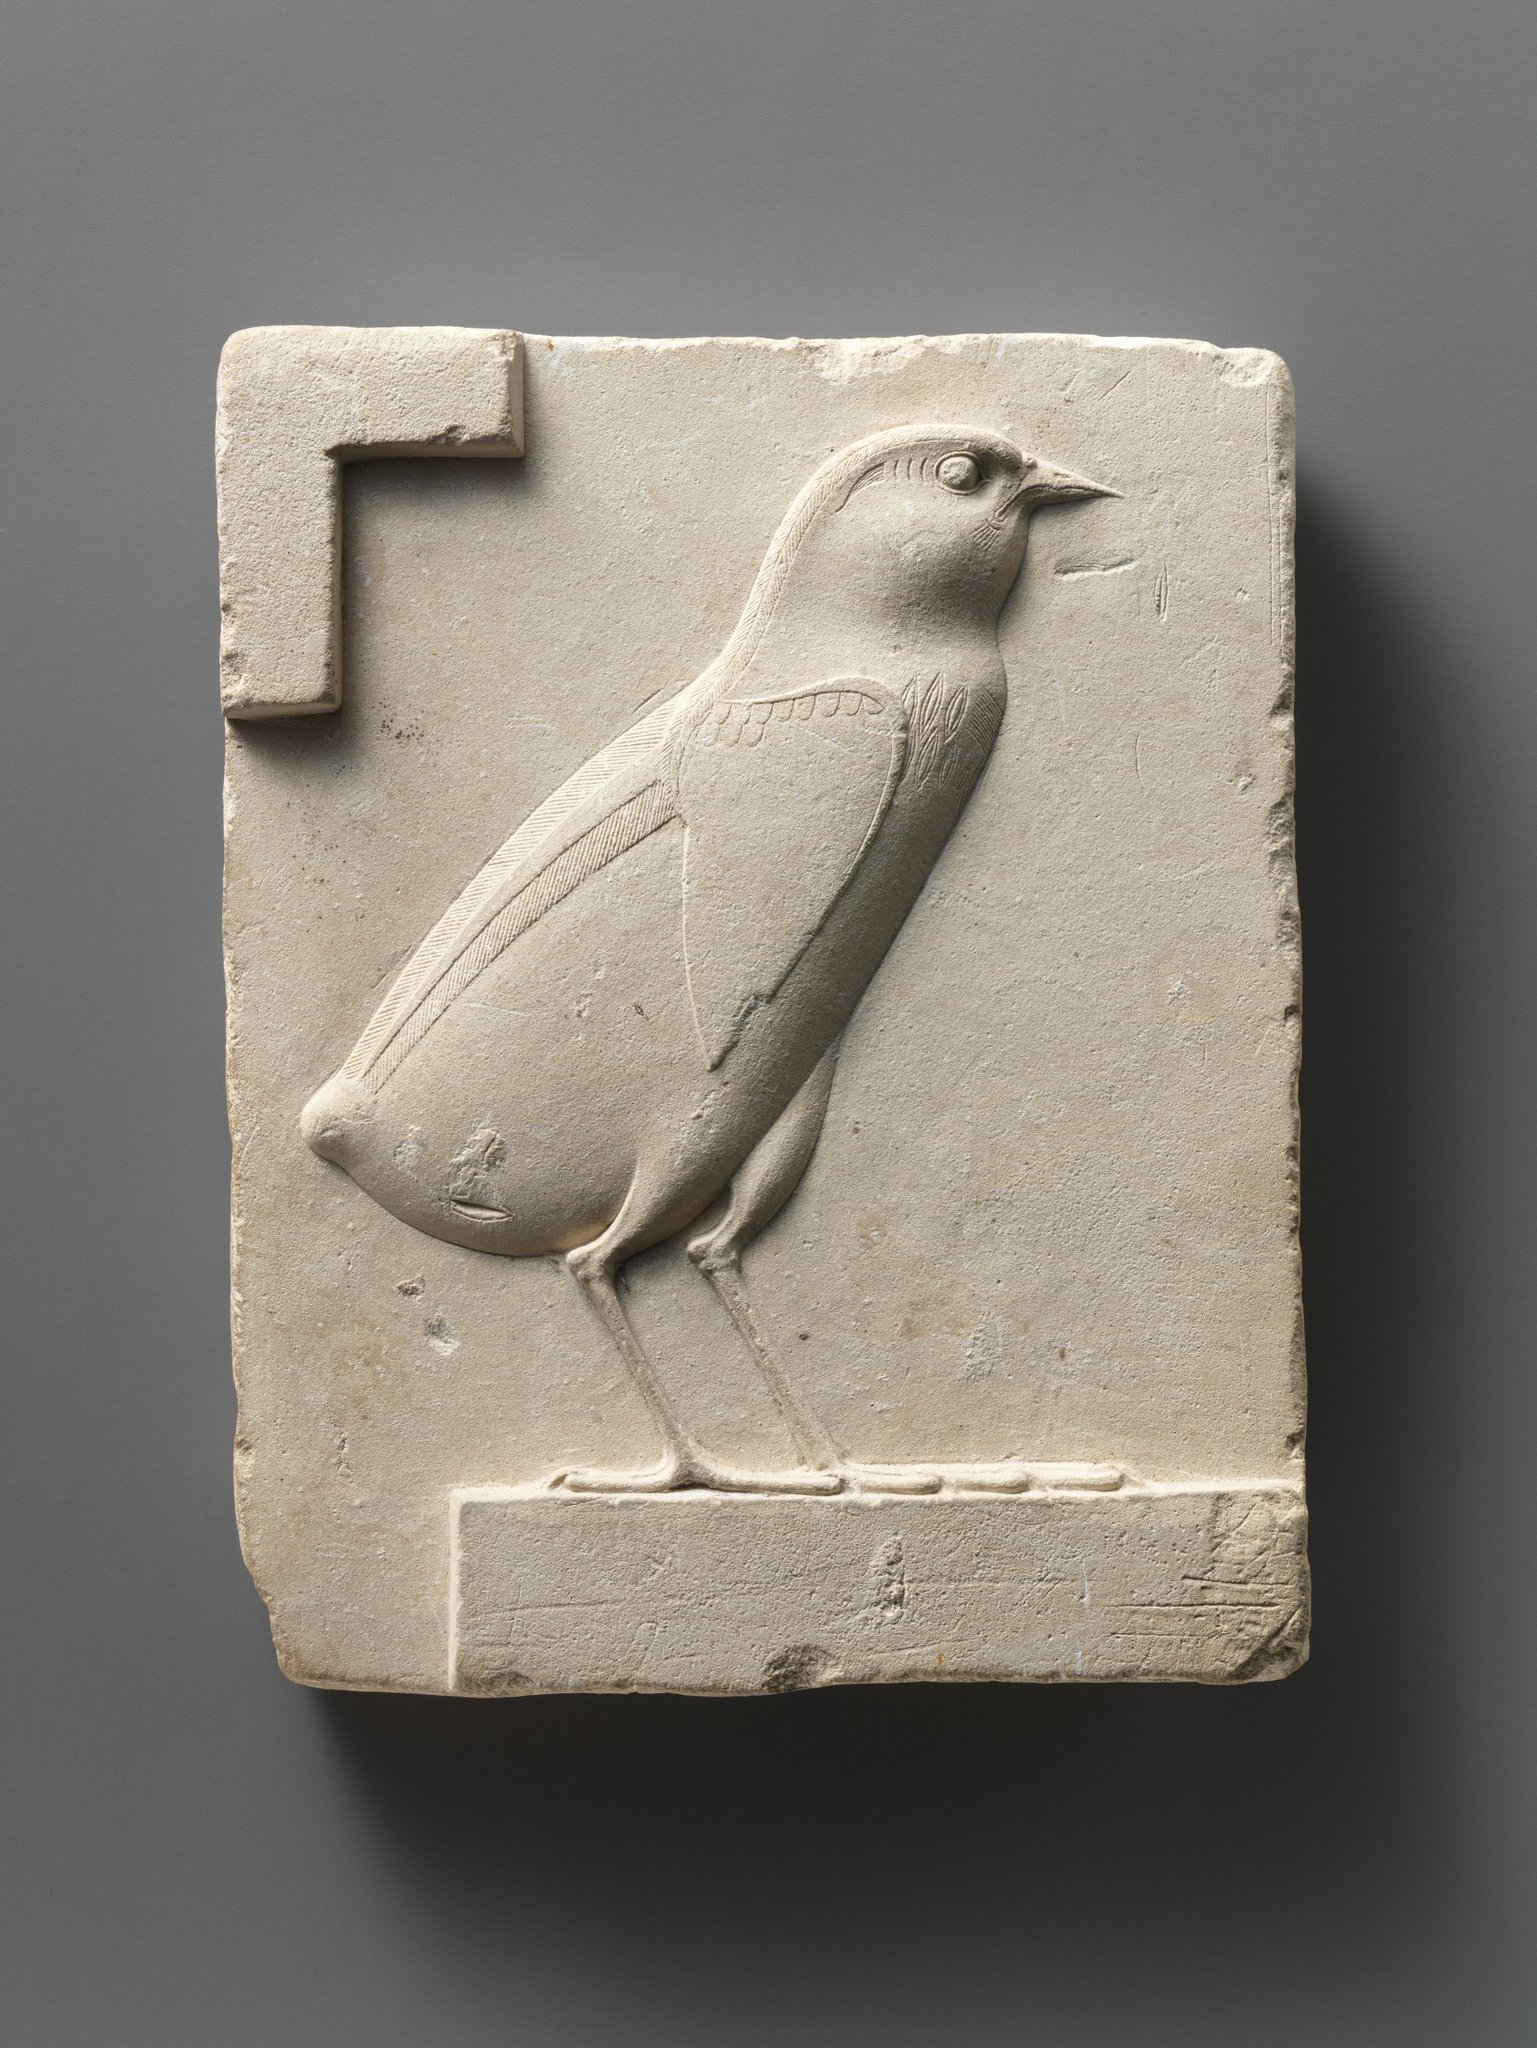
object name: sculptor's model votive, chick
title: Relief plaque with quail chick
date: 400-30 BCE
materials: limestone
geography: egypt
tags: birds